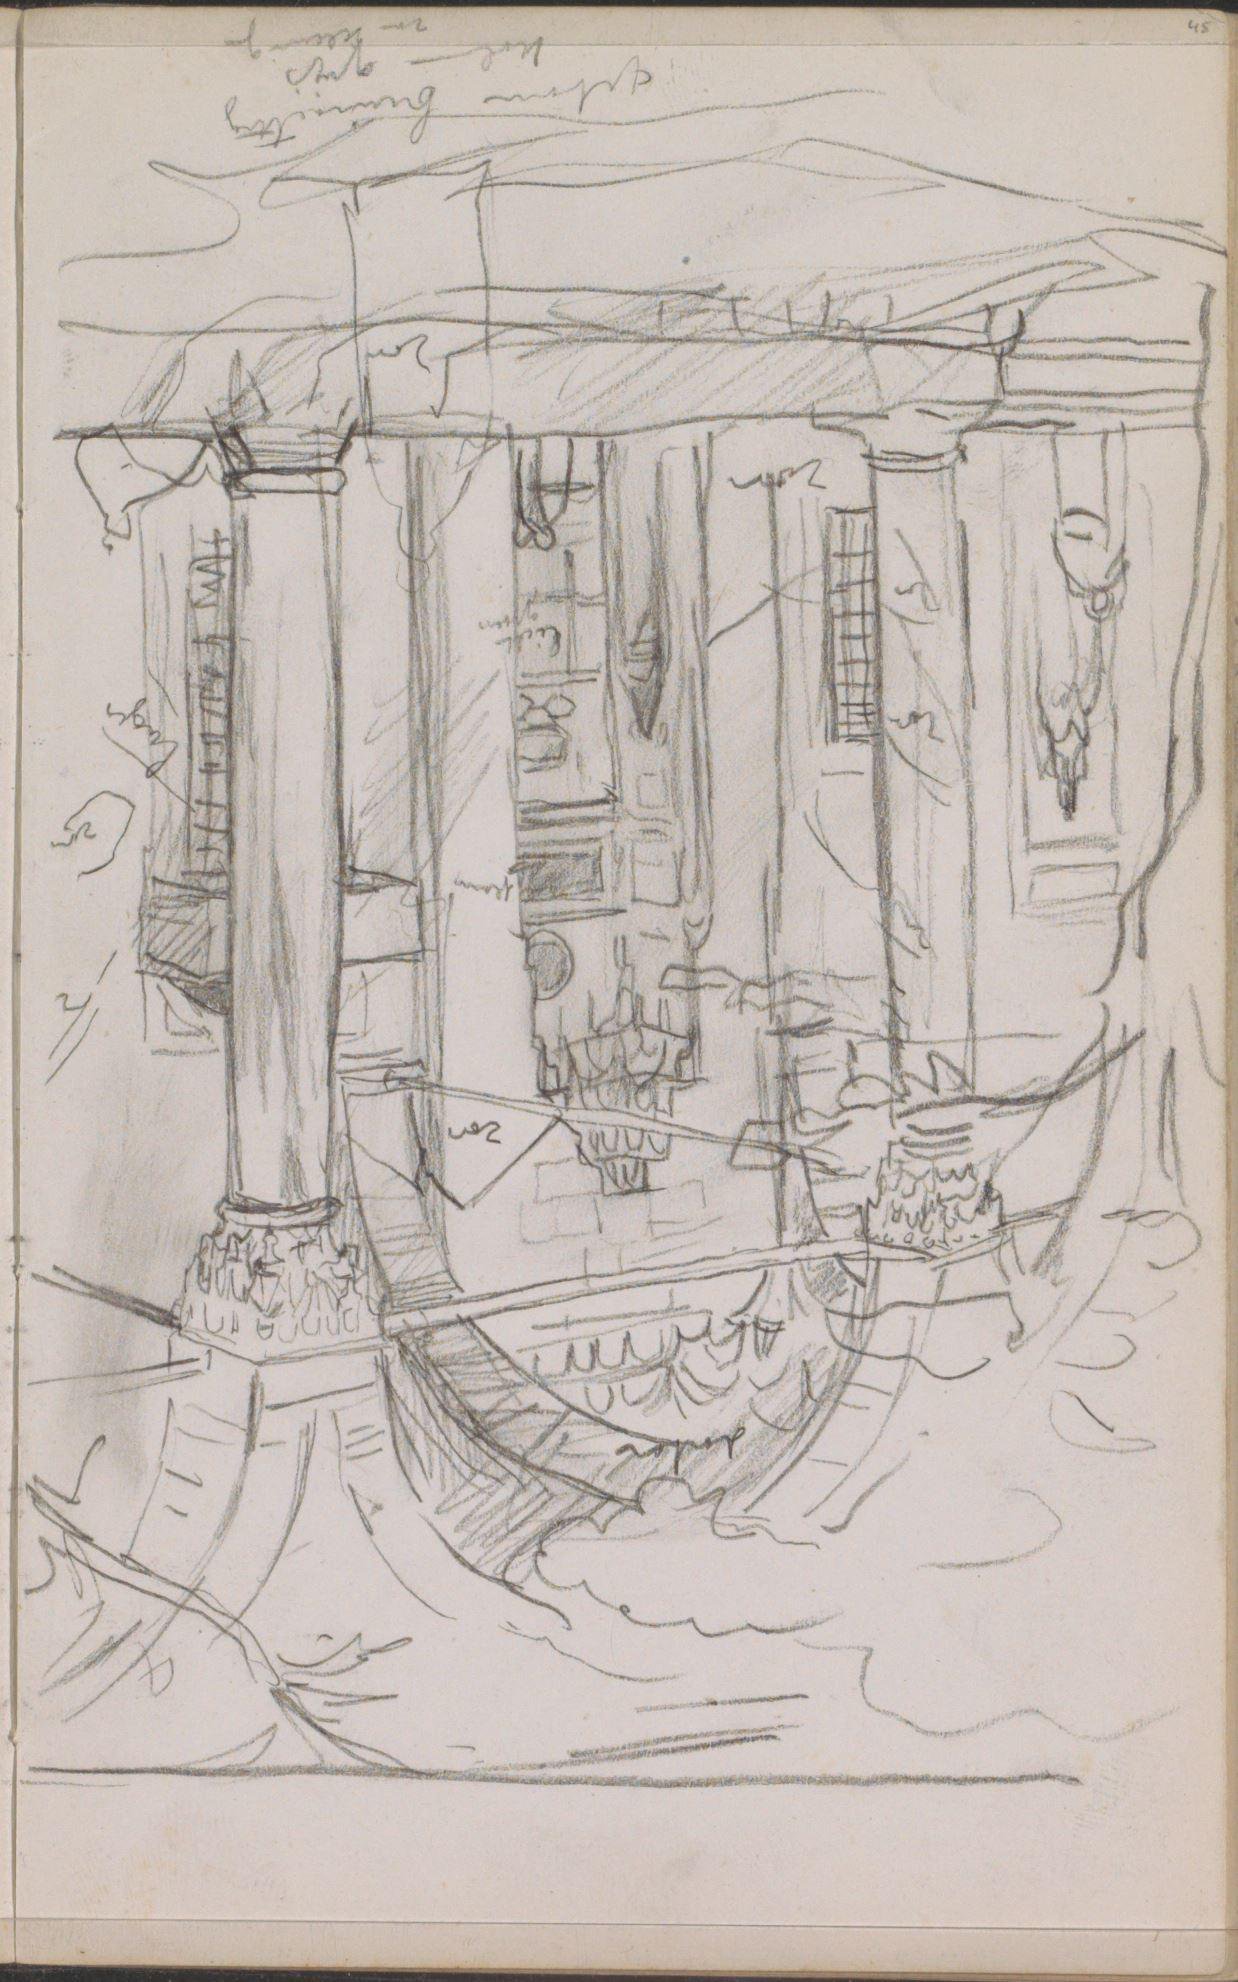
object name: sketchbook leaf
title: Voorportaal van een gebouw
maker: marius bauer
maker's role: draughtsman, print maker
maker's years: 1867-1932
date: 1896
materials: chalk, paper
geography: turkey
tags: standing figure, sitting figure, flight of steps, column, pillar ~ architecture, arch, archivolt ~ architecture, architecture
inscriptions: kleurnotitie, handgeschreven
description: Bij het portaal staan en zitten enkele figuren. Pagina 45 uit een schetsboek met 53 bladen.